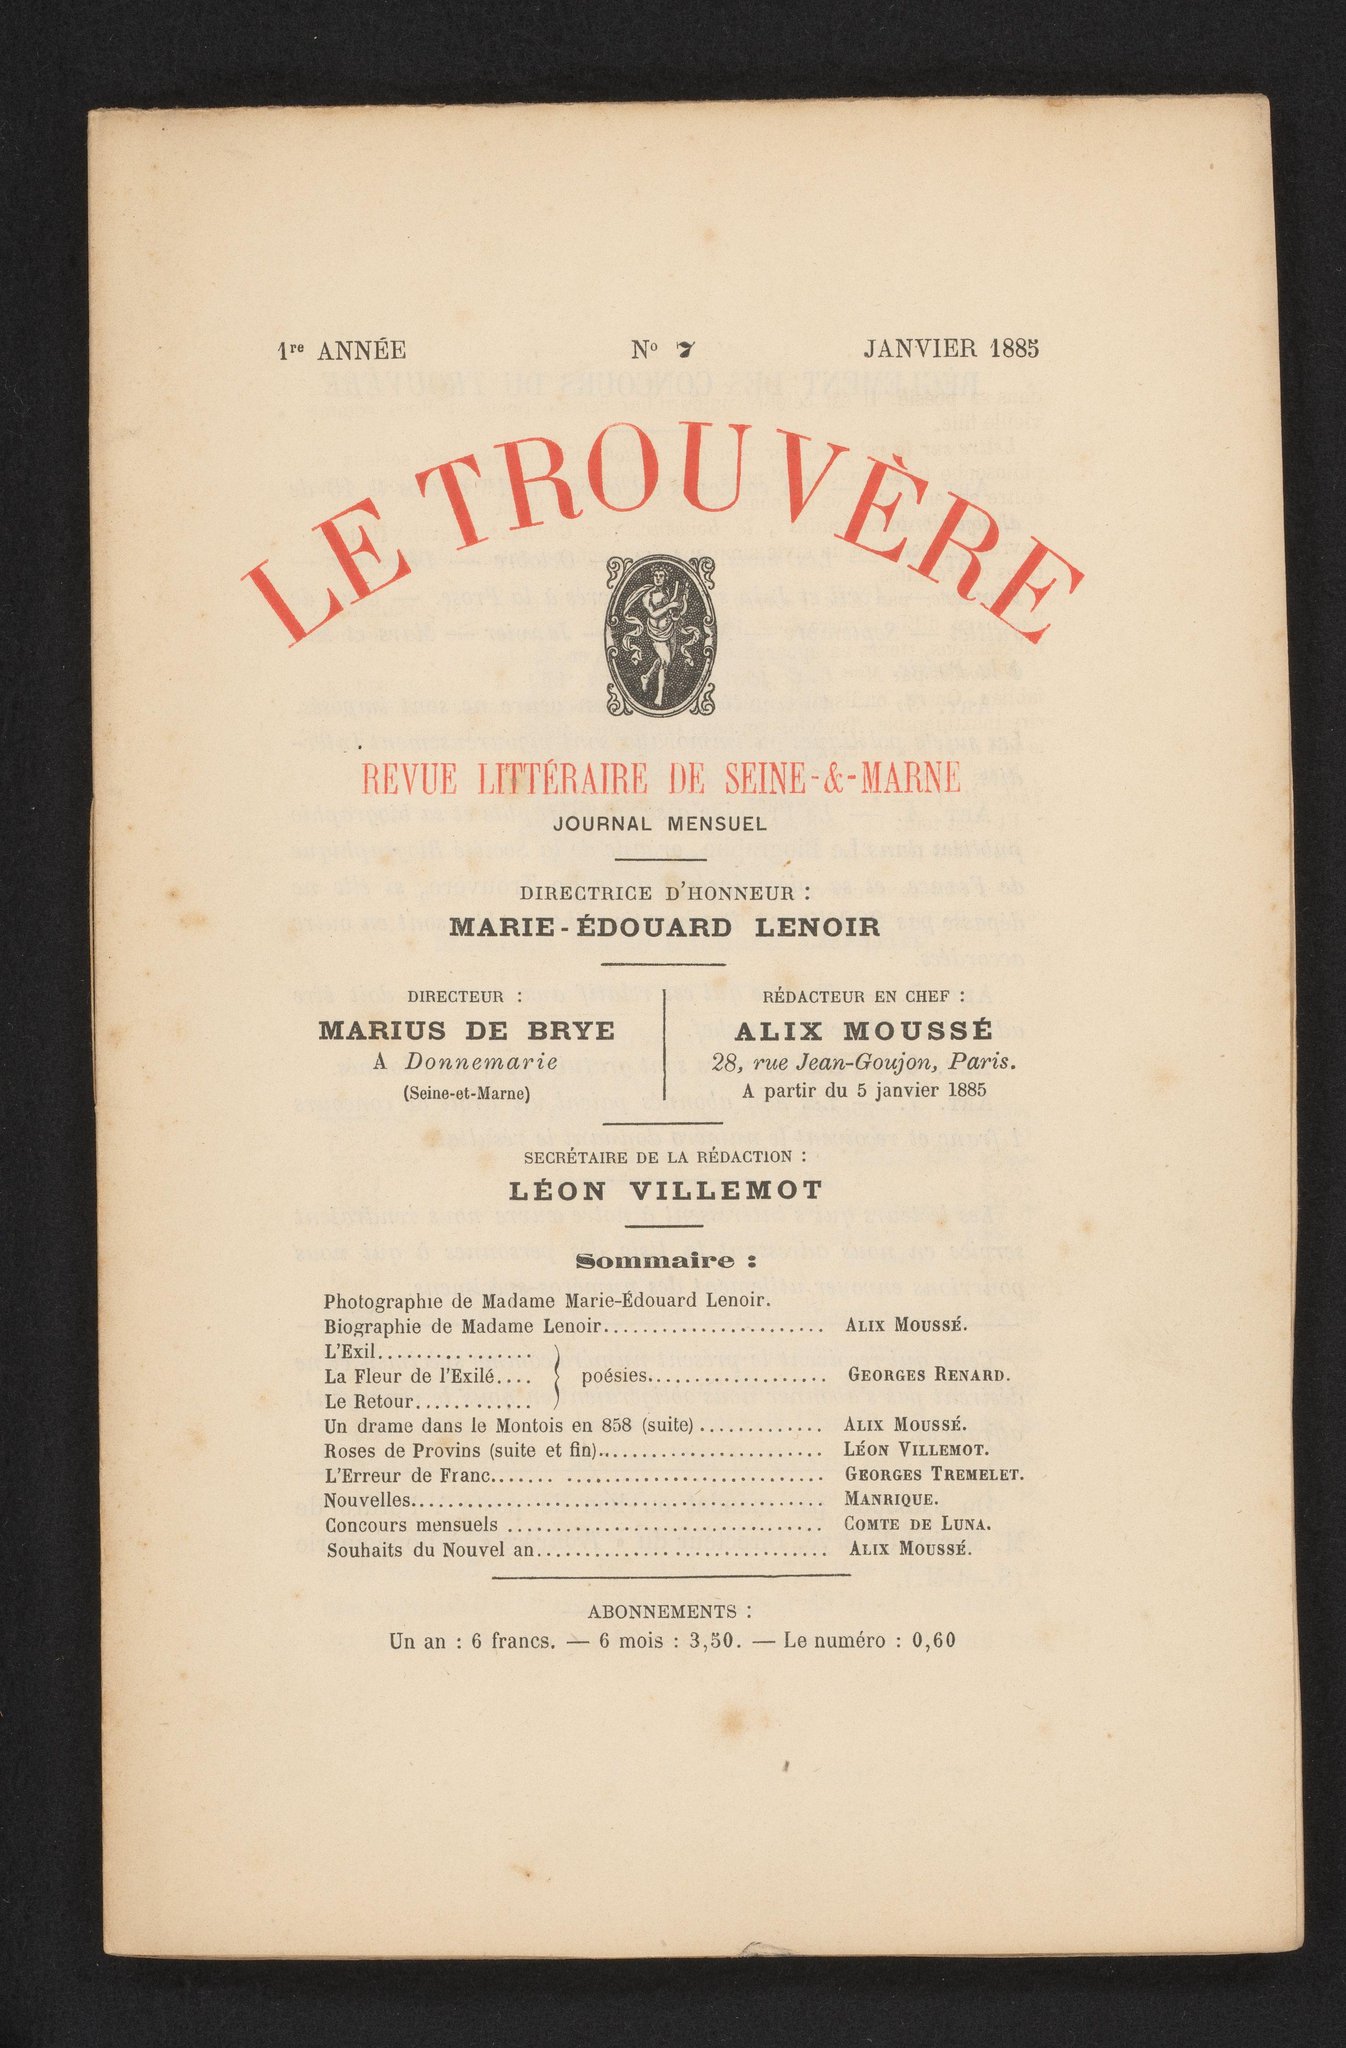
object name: book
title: Le trouvère No 7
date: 1801-1885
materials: paper, photographic support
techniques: albumen print, printing, engraving